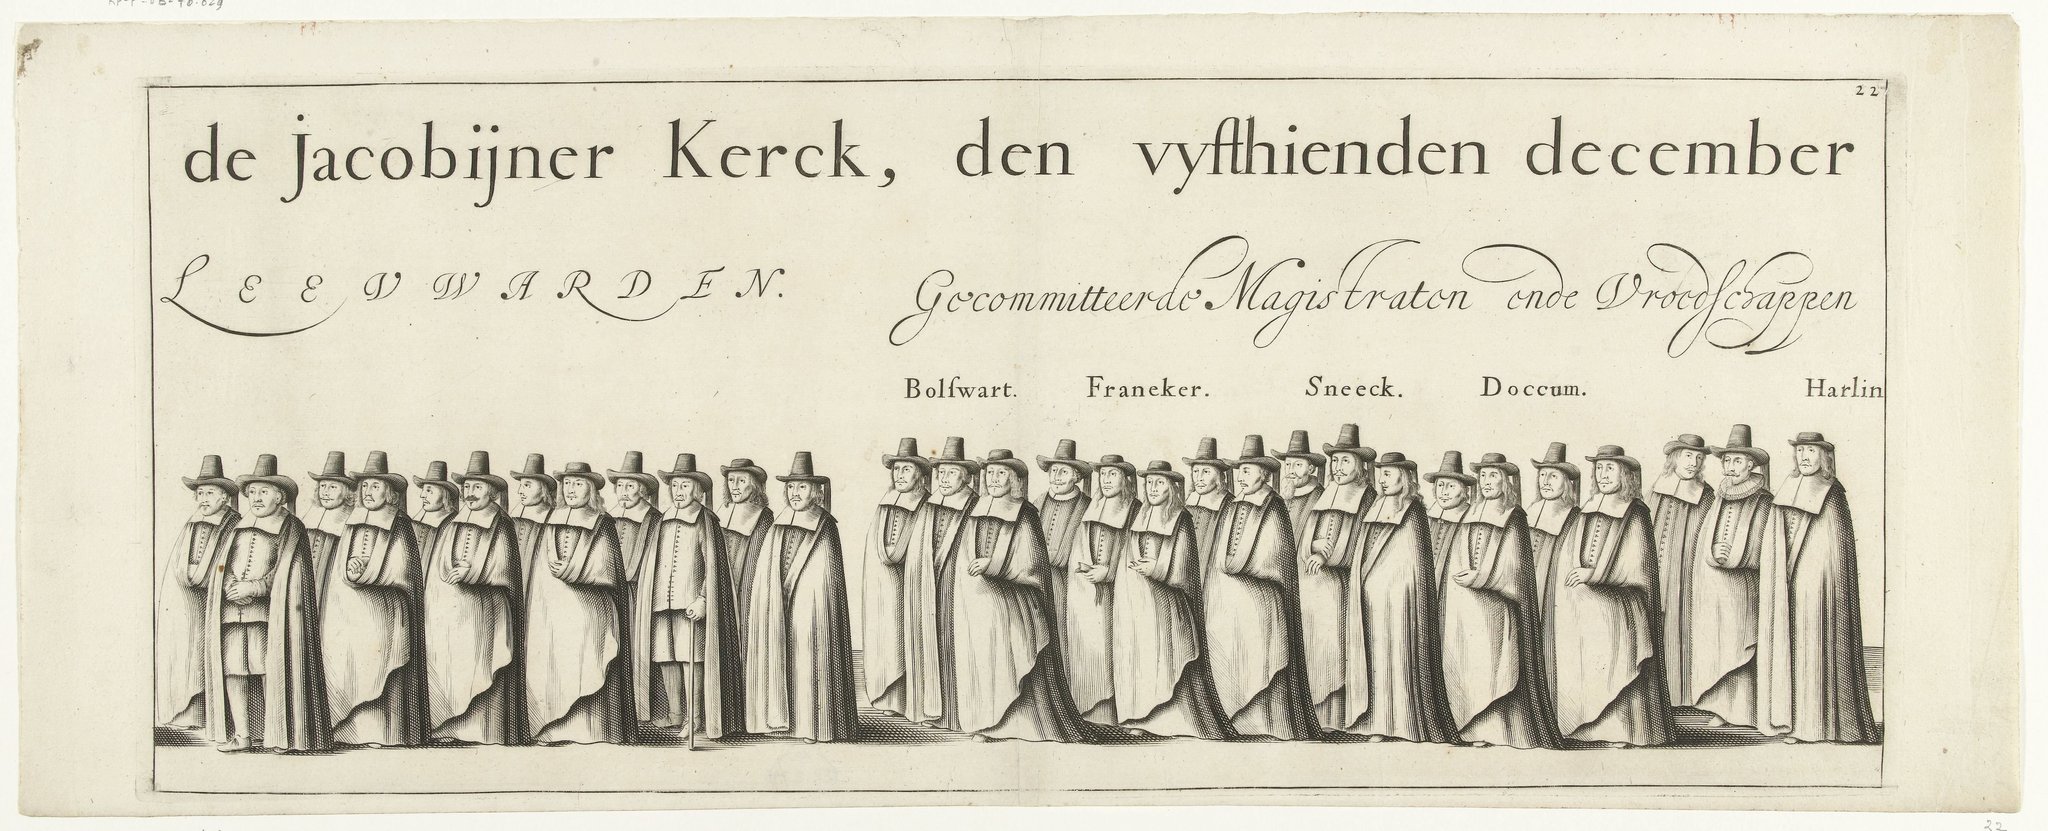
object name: print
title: Rouw-Staetelijcke Lijk-pracht in de Uyt-Vaert en Begraefenisse van het ont-zielde Lichaem van (...) Wilhelm Frederich (...) Overleden binnen Leeuwarden (...) den een-en-twintichsten October, MDCLXIV. en aldaer in 't Choor van de Jacobijner Kerck, den vyfthienden december MDCLXIV. Oude Stijl (...)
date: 1666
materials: paper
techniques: engraving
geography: leeuwarden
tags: arnhem, cortege, funeral procession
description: Begrafenisoptocht van Willem Frederik, graaf van Nassau-Dietz, in Leeuwarden op 6 januari 1665. Deel van de begrafenisstoet. Plaat nr. 22 in een ensemble van 25 ongemonteerde genummerde platen en twee tekstbladen die samen een lange fries vormen.